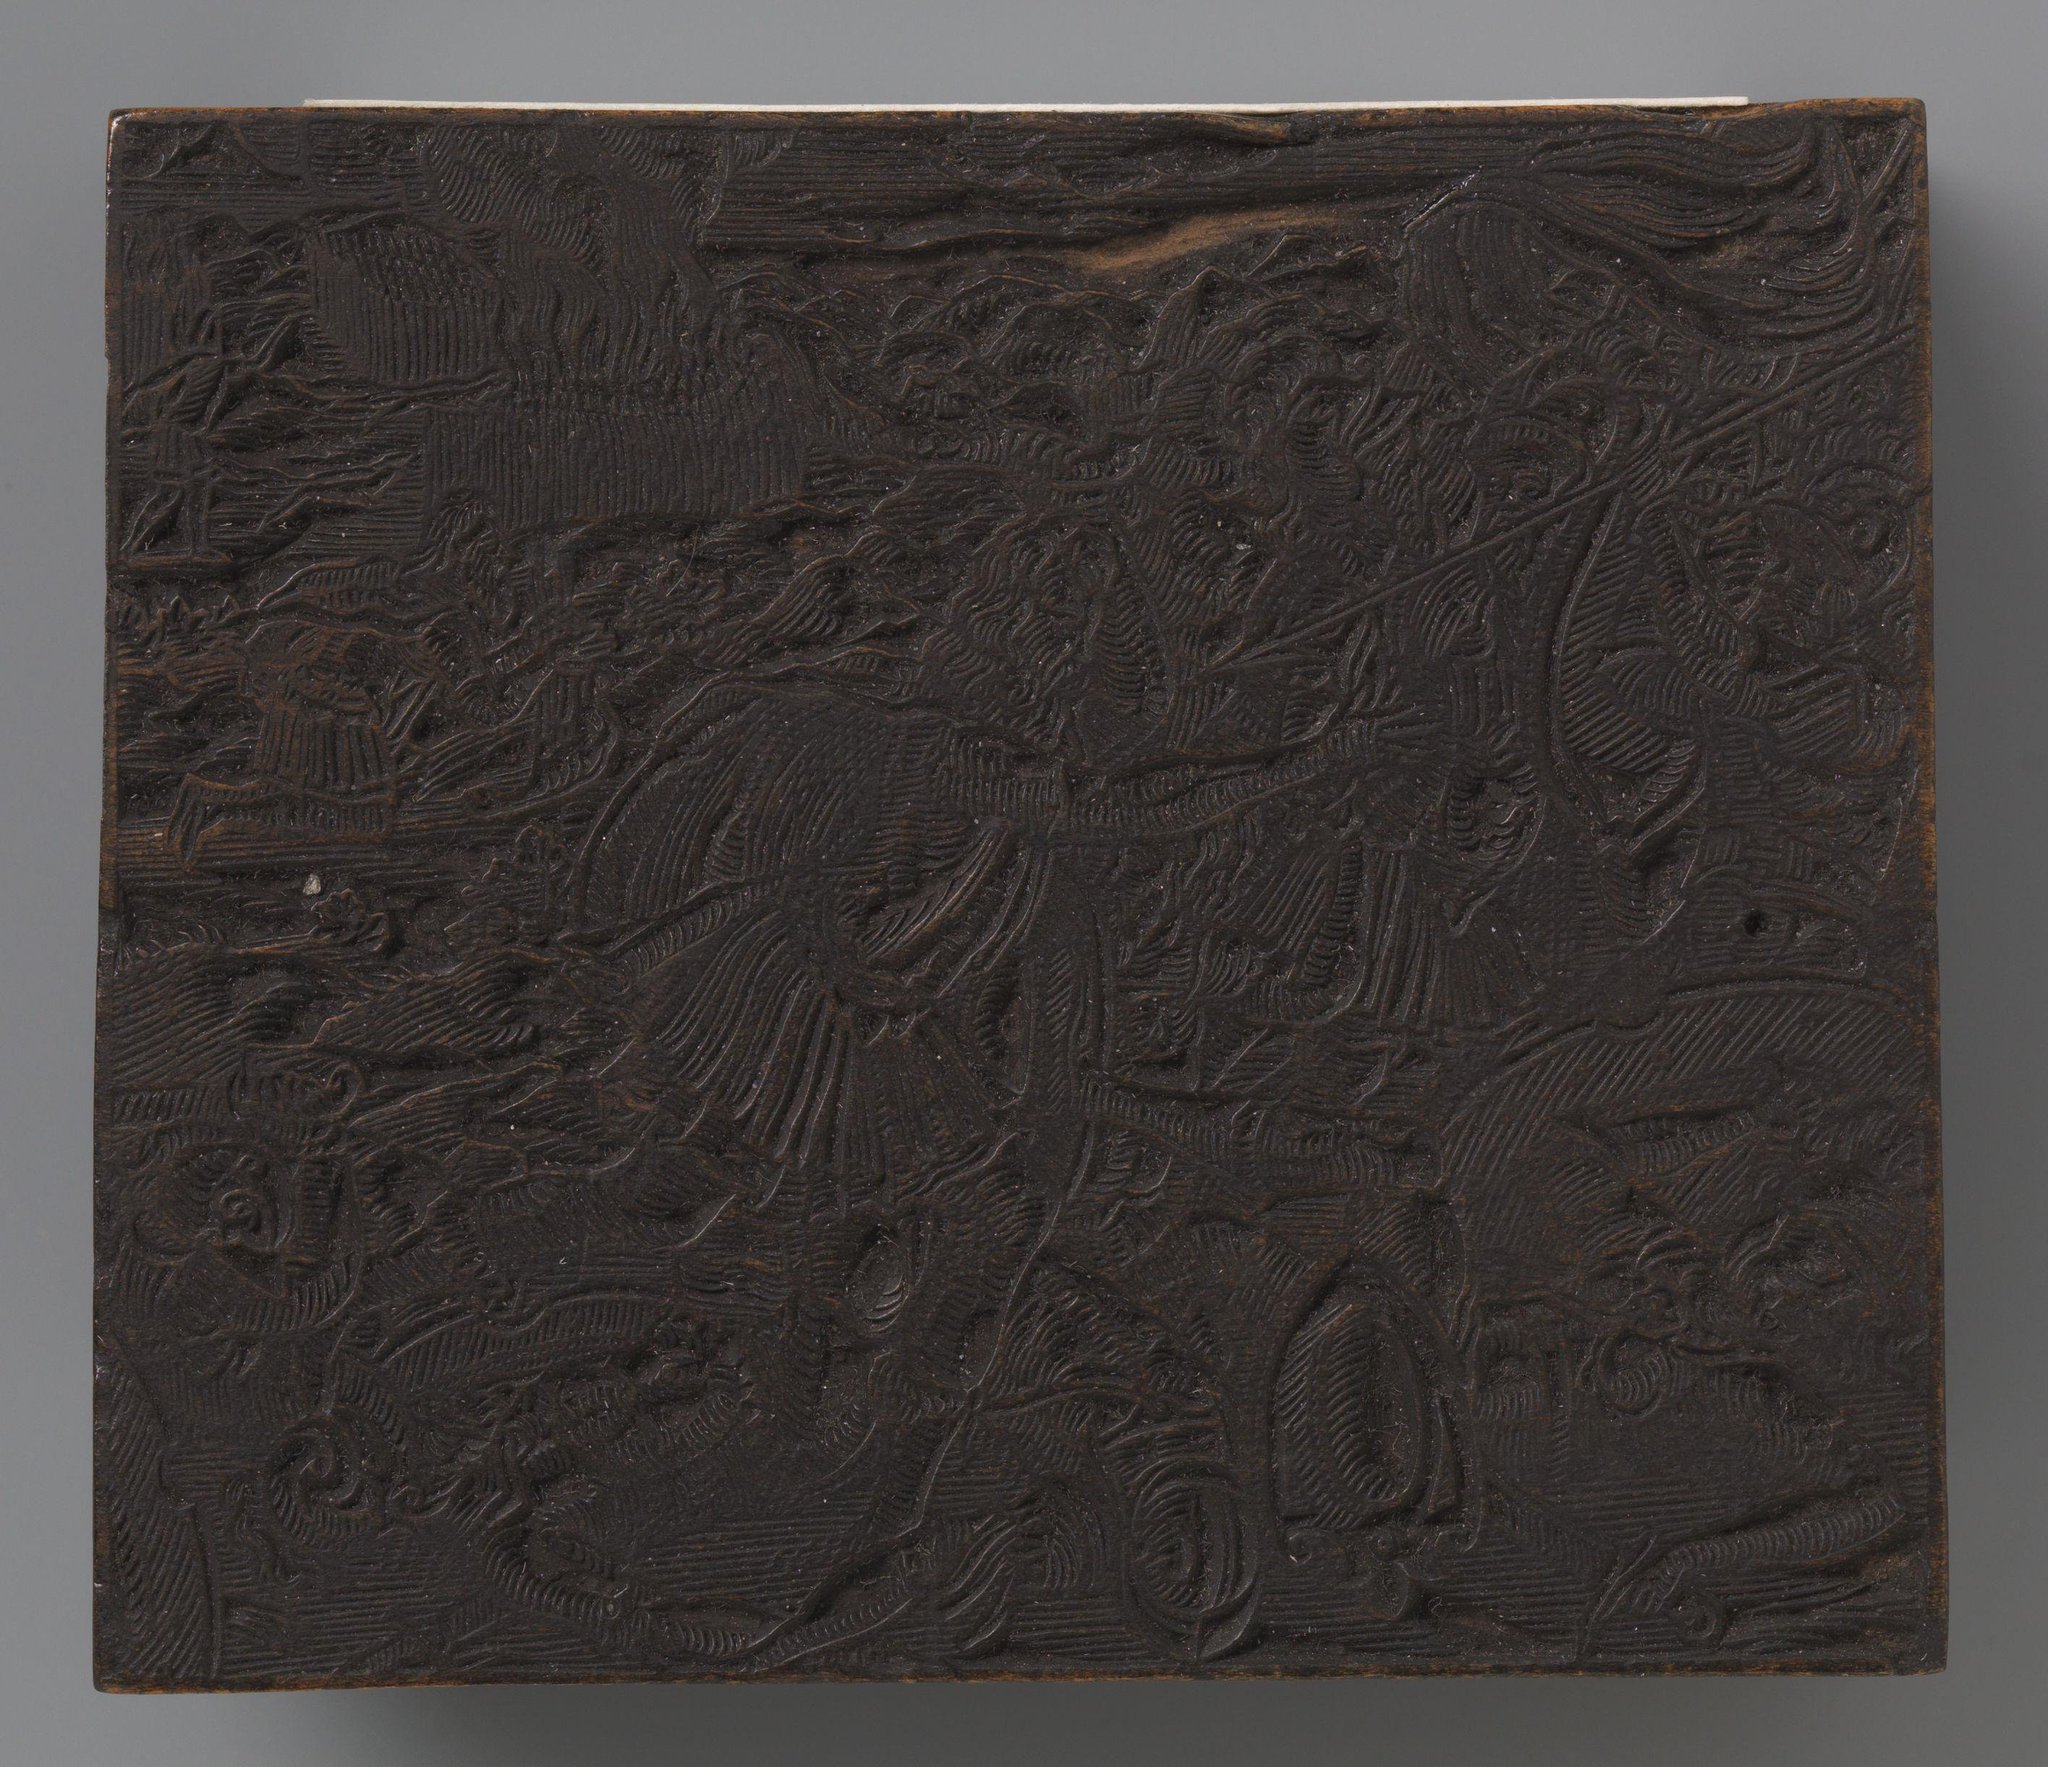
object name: wood block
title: Simson verslaat de Filistijnen met een ezelskaak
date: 1524-1650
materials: wood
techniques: woodcut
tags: with an ass's jaw-bone samson slays a thousand philistines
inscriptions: inscription: ‘Monogr. HL./ Johan v. Esser’